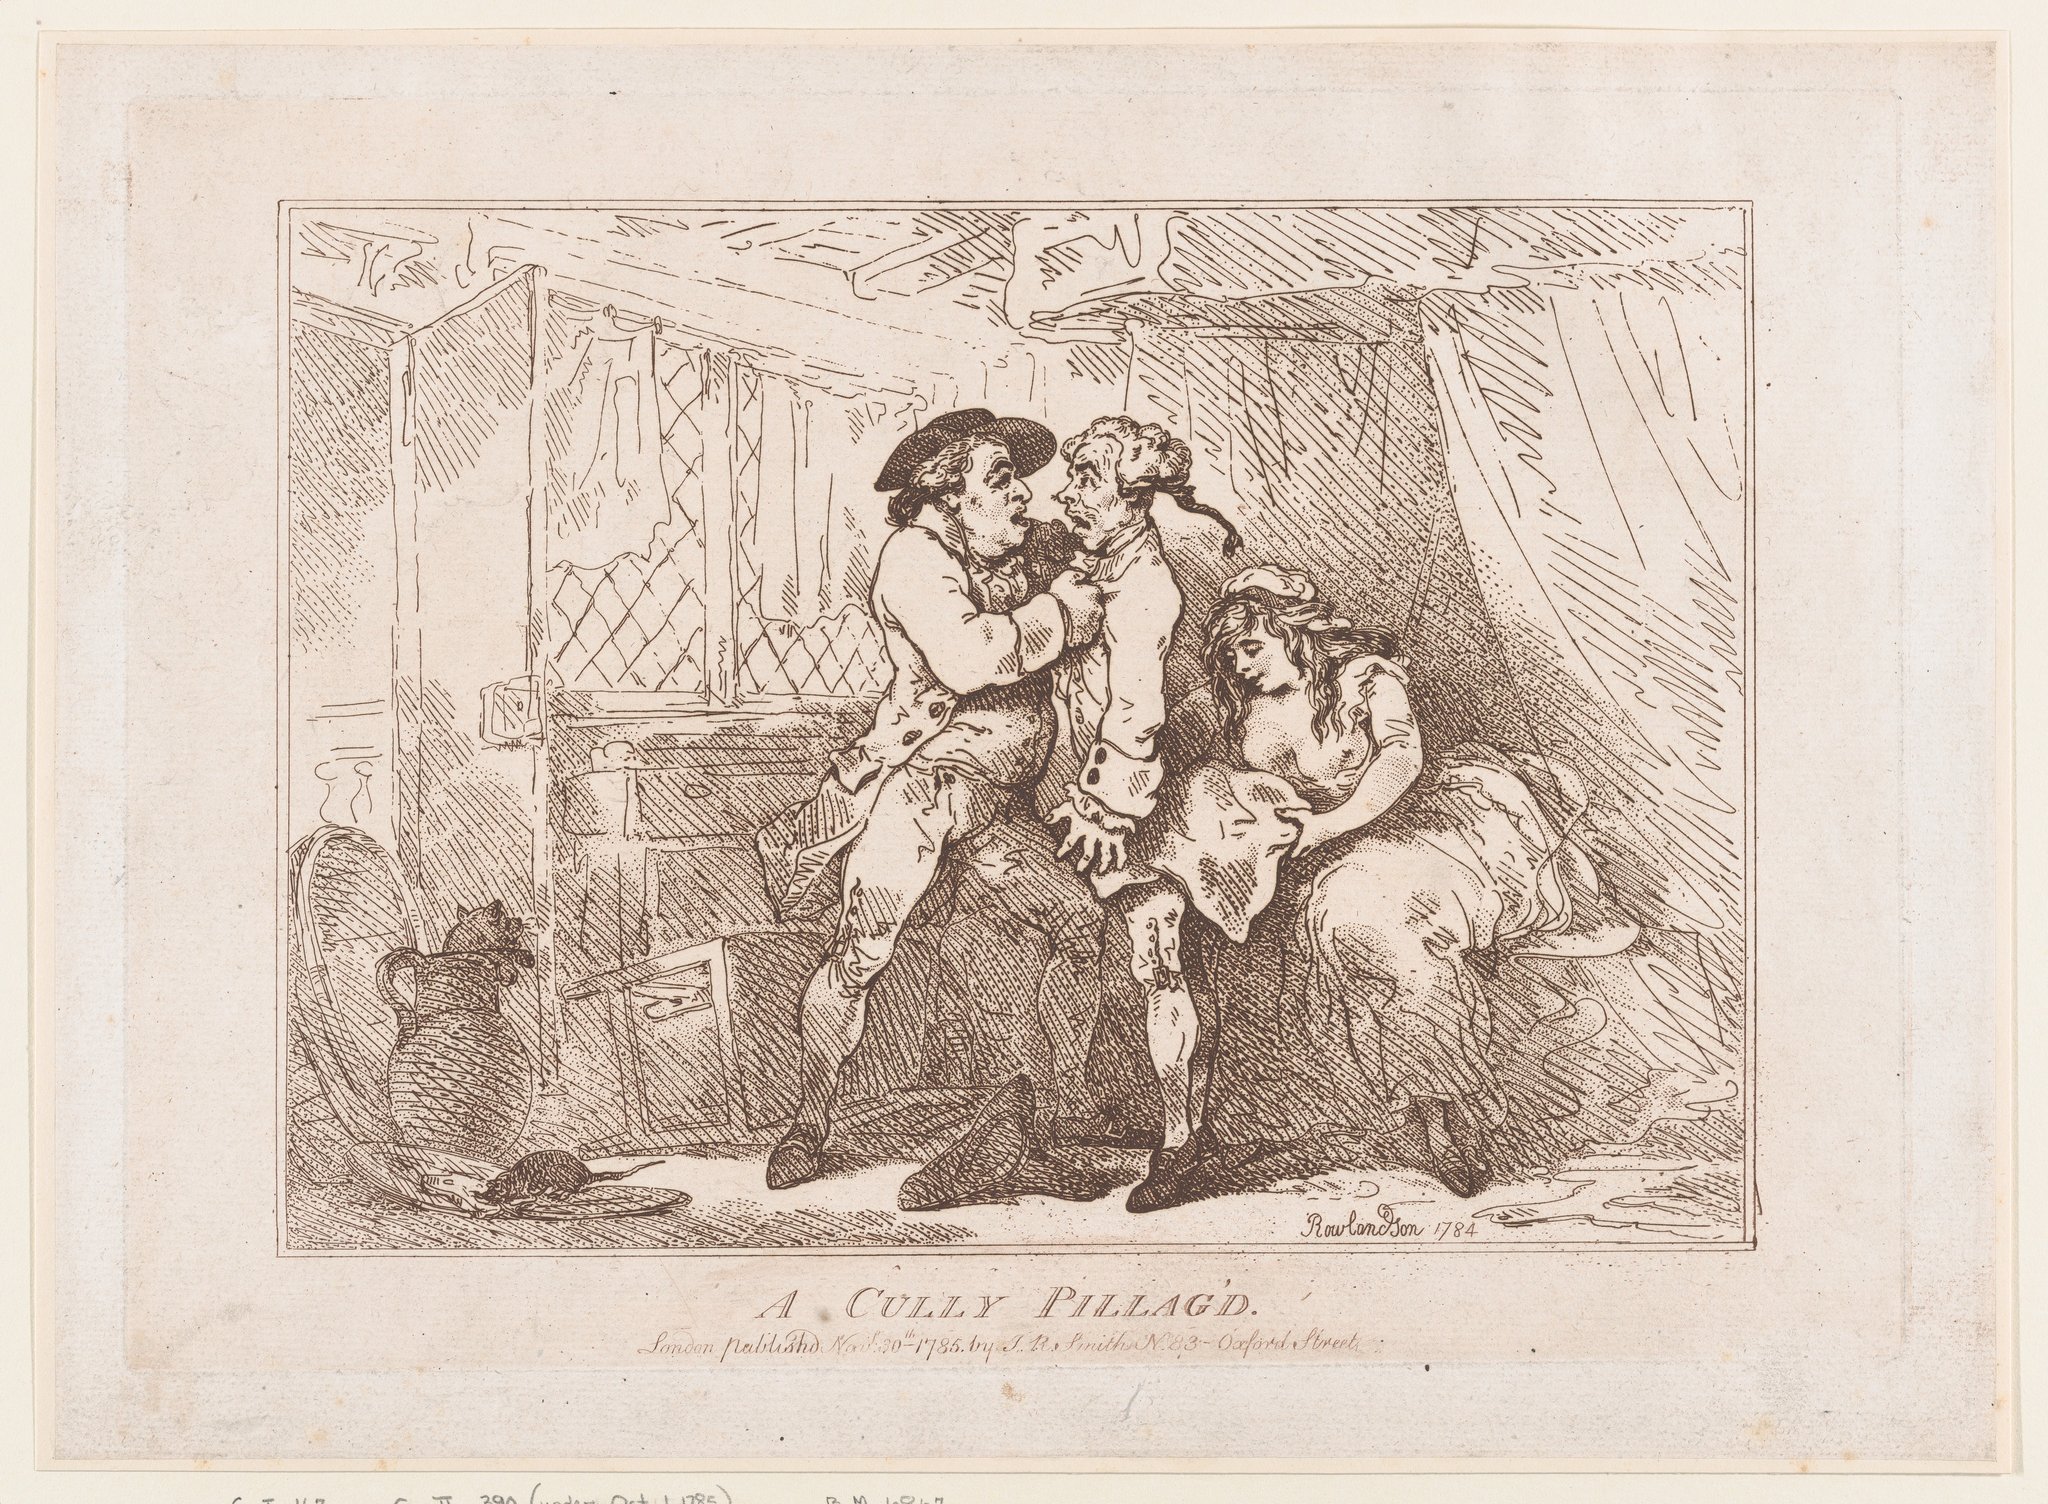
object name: print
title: A Cully Pillag'd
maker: thomas rowlandson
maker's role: artist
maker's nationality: british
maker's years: 1757-1827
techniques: etching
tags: men,women